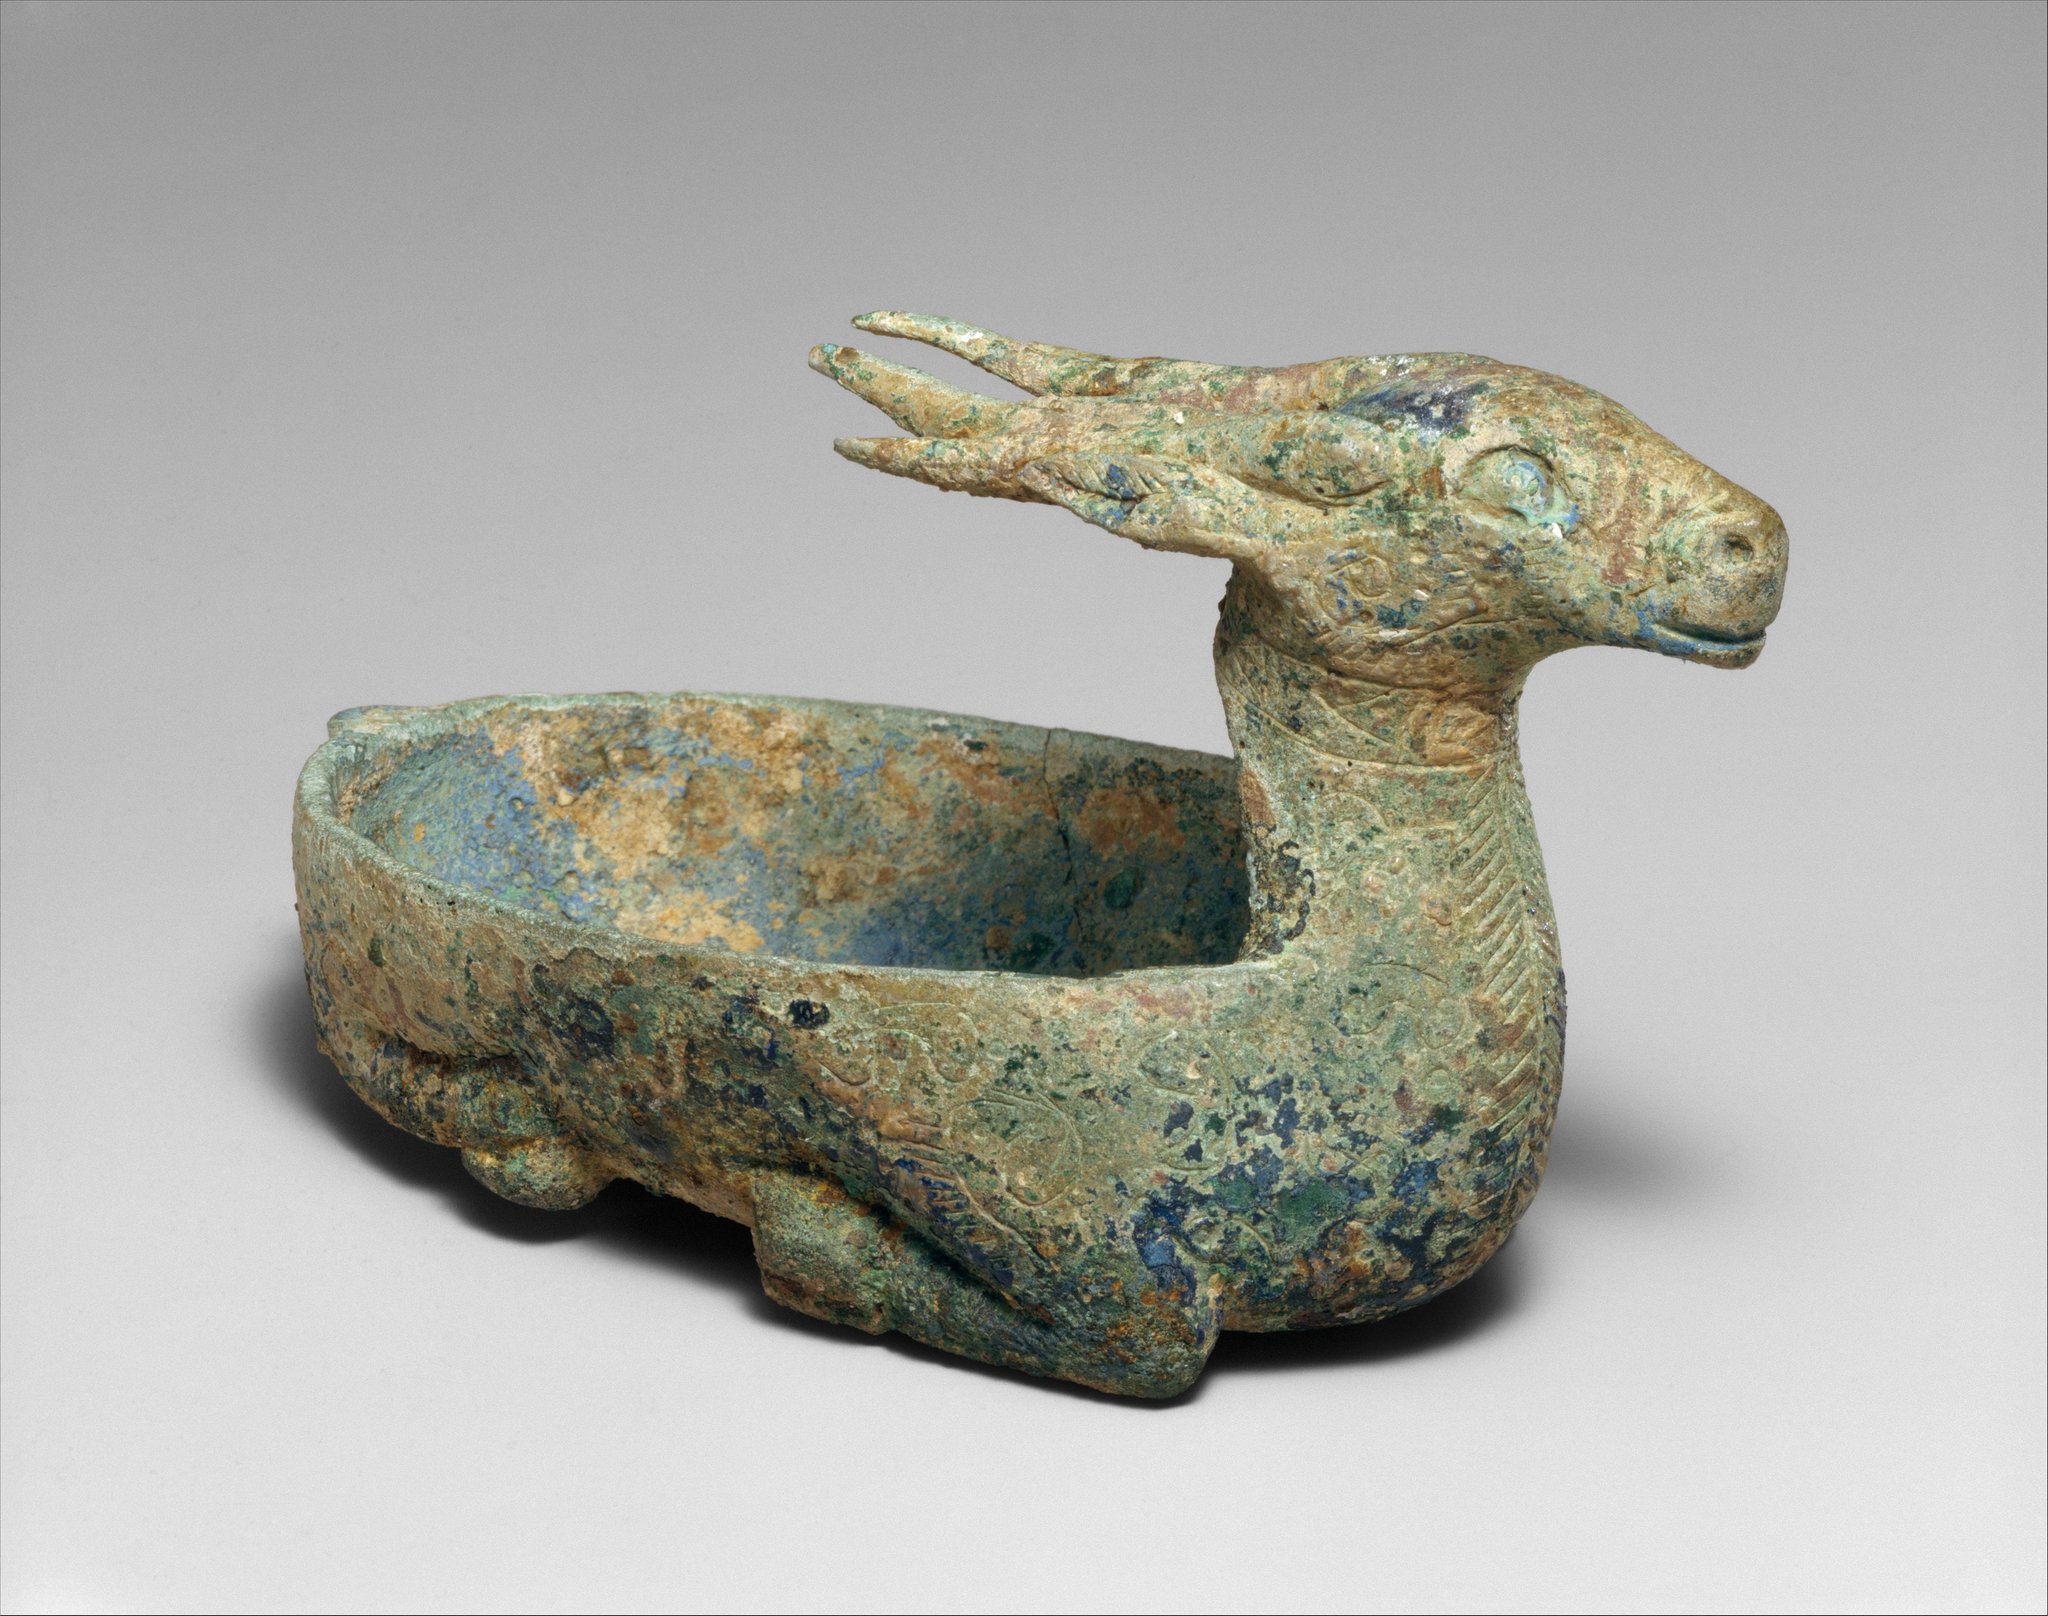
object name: weight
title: Mat Weight in the Shape of a Doe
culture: chinese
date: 100 BCE-100 CE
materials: bronze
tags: deer